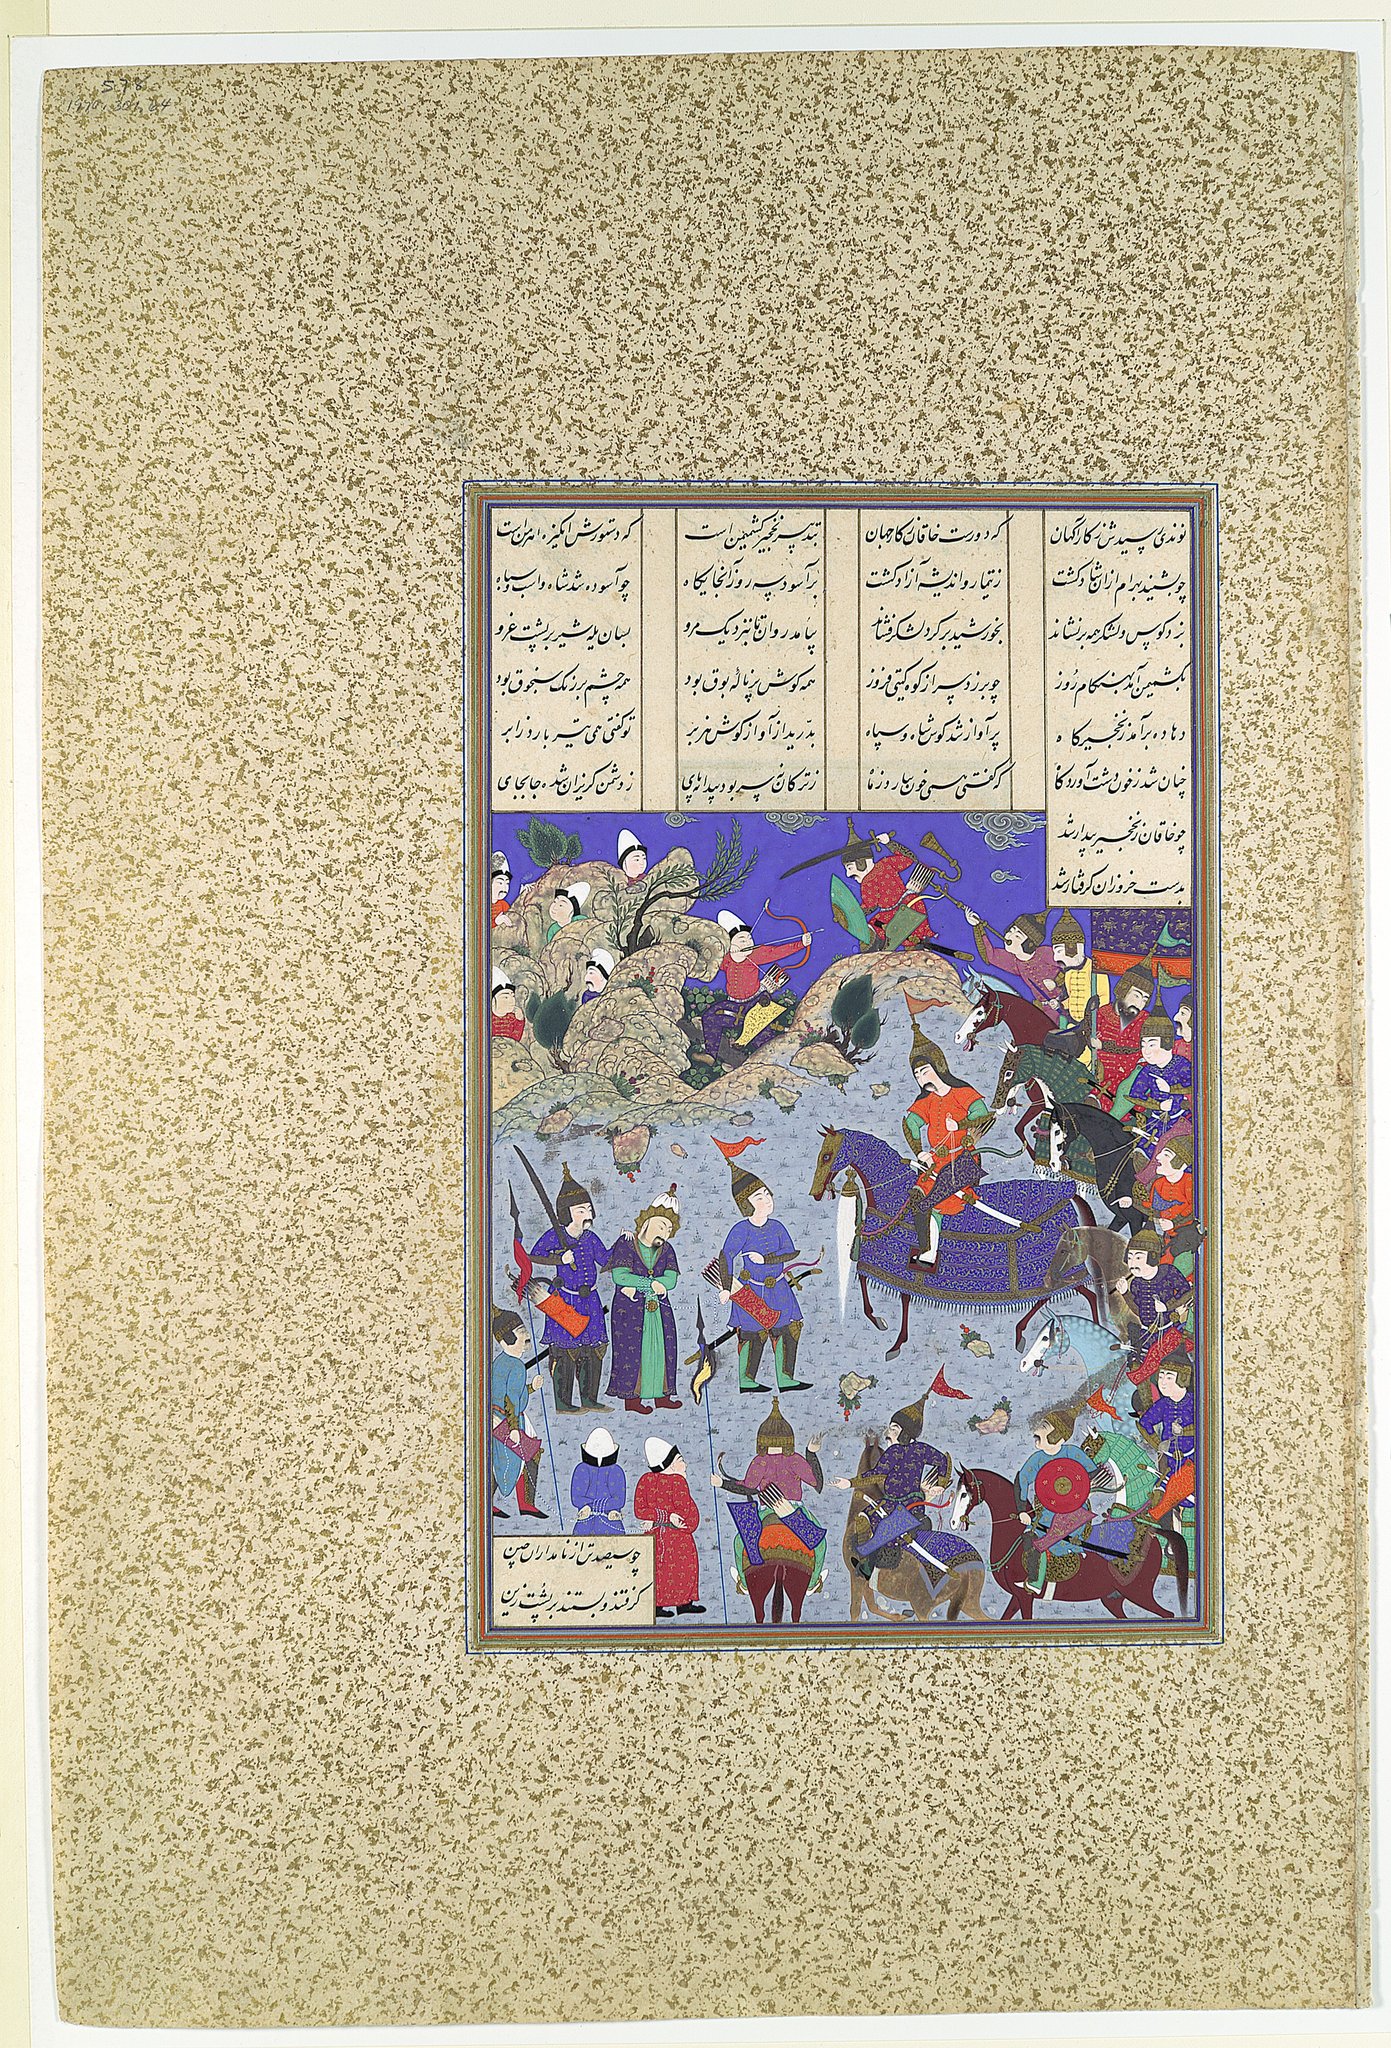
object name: folio from an illustrated manuscript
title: "The Khaqan Captive Before Bahram Gur", Folio 578r from the Shahnama (Book of Kings) of Shah Tahmasp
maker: abu'l qasim firdausi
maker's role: author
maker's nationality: iranian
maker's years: 935-1020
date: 1530-1535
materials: gold, ink, paper, silver, watercolor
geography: iran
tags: battles,army,men,horses